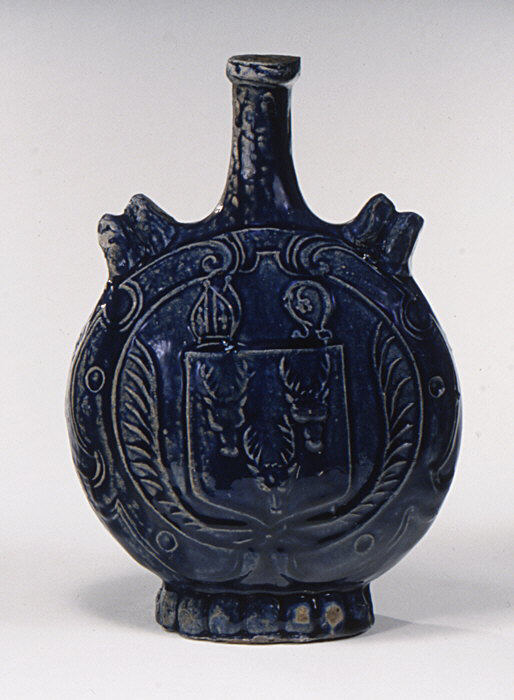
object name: pilgrim bottle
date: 1601-1700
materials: stoneware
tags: human figures,deer